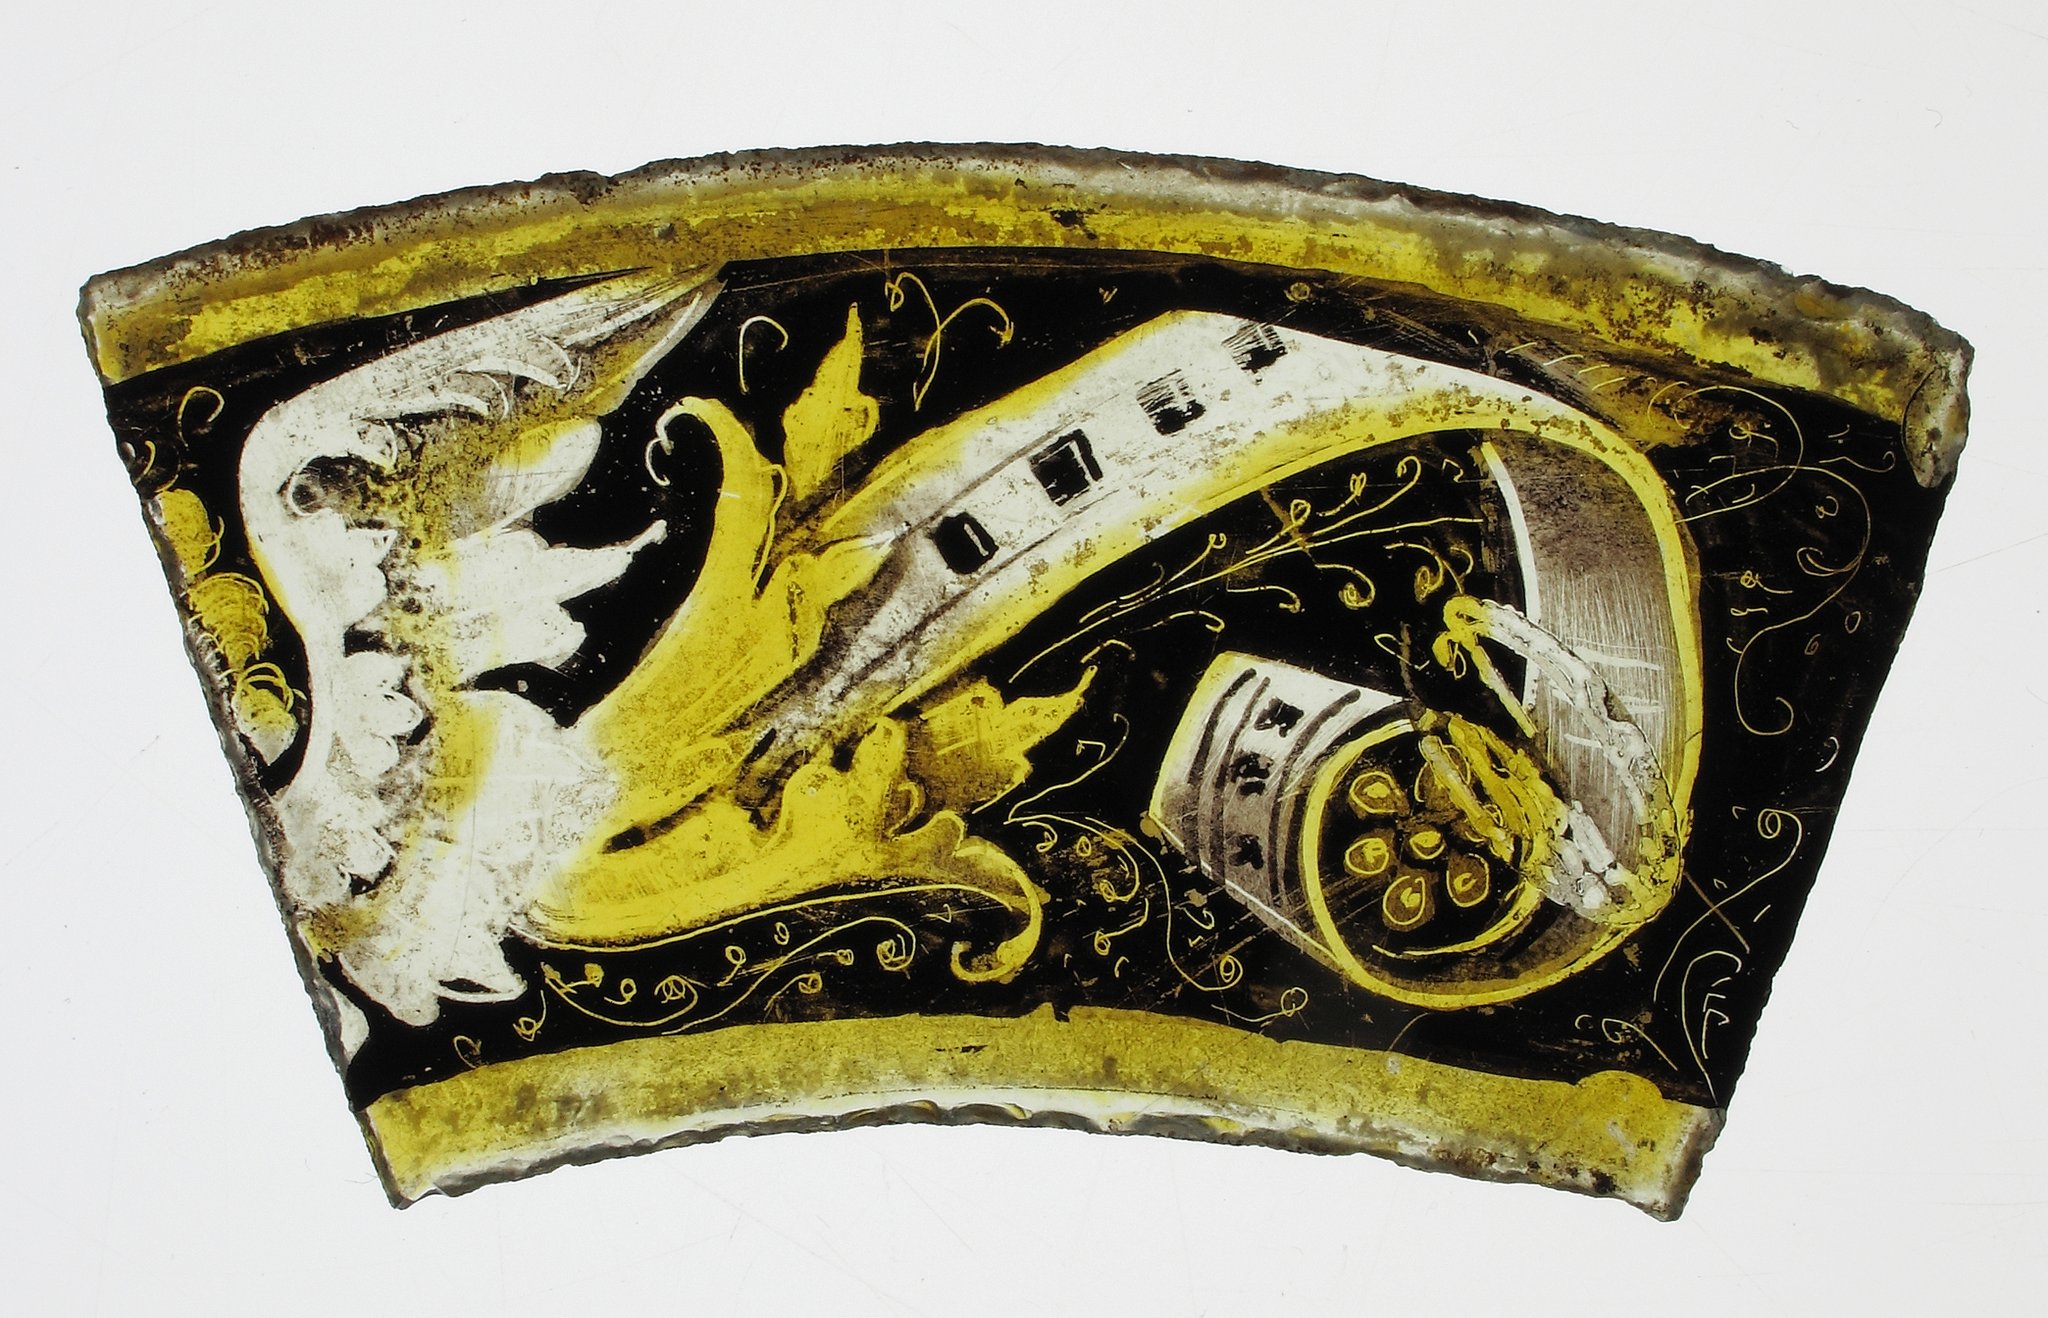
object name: fragment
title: Glass Fragment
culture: european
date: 1501-1600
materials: glass